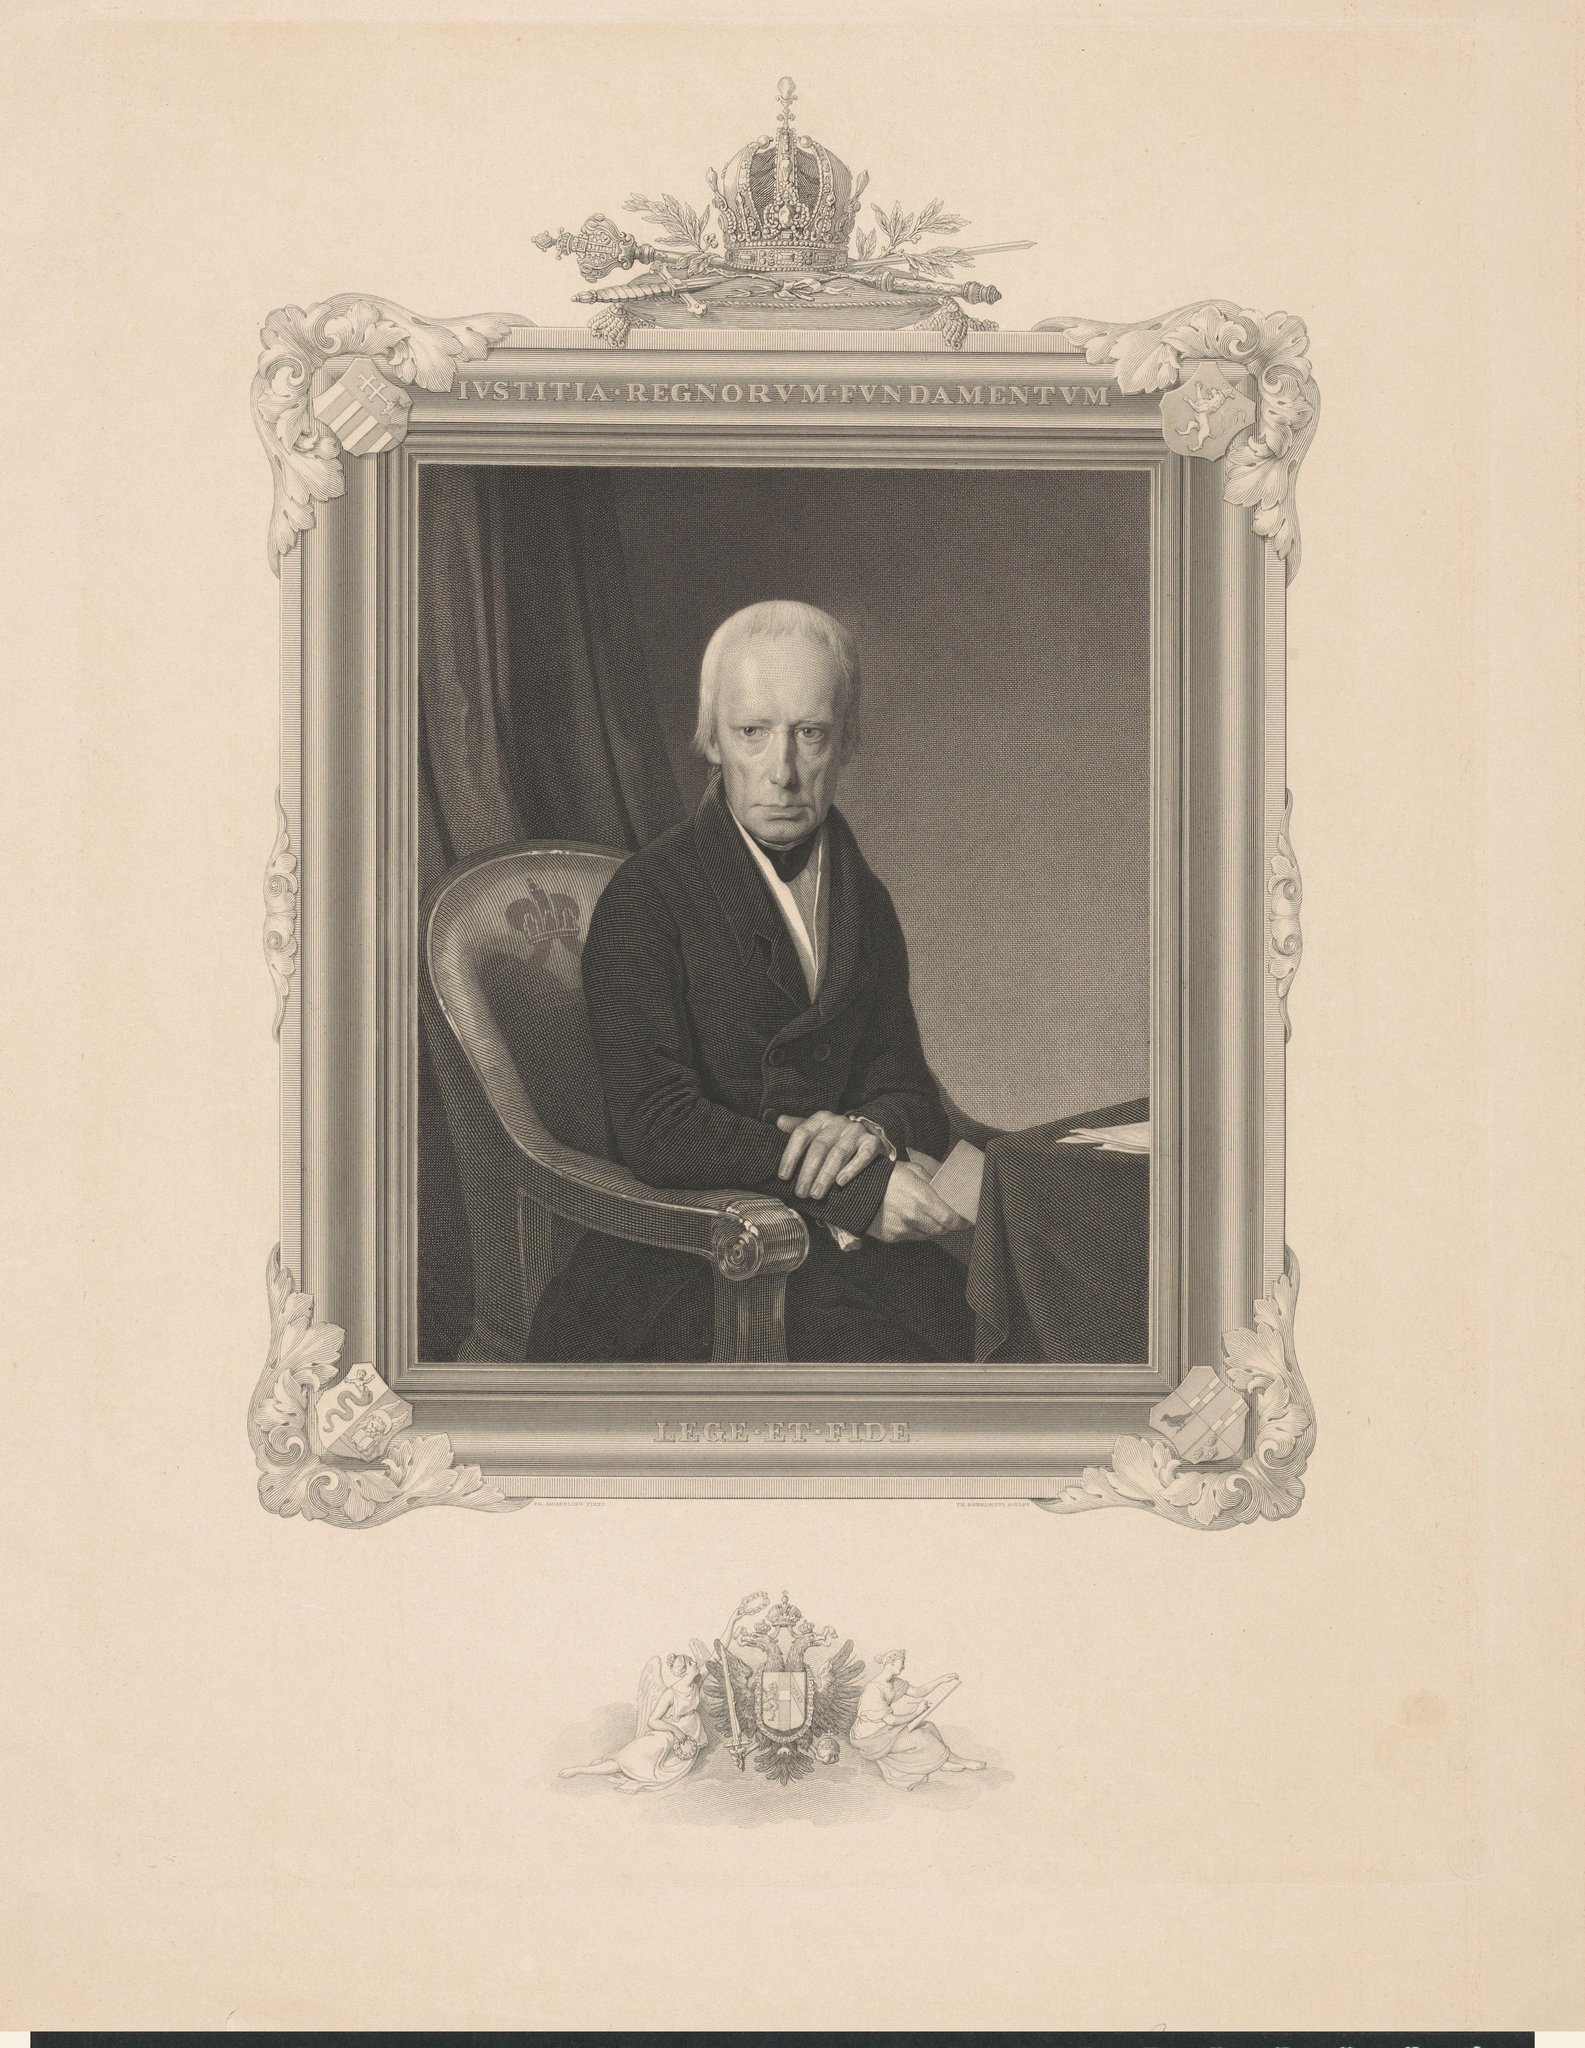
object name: print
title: Portret van keizer Frans II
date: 1806-1863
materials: paper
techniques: engraving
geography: italy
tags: vienna, frans ii (rooms-duits keizer), historical persons, ruler, sovereign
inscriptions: collector's mark: Lugt 12